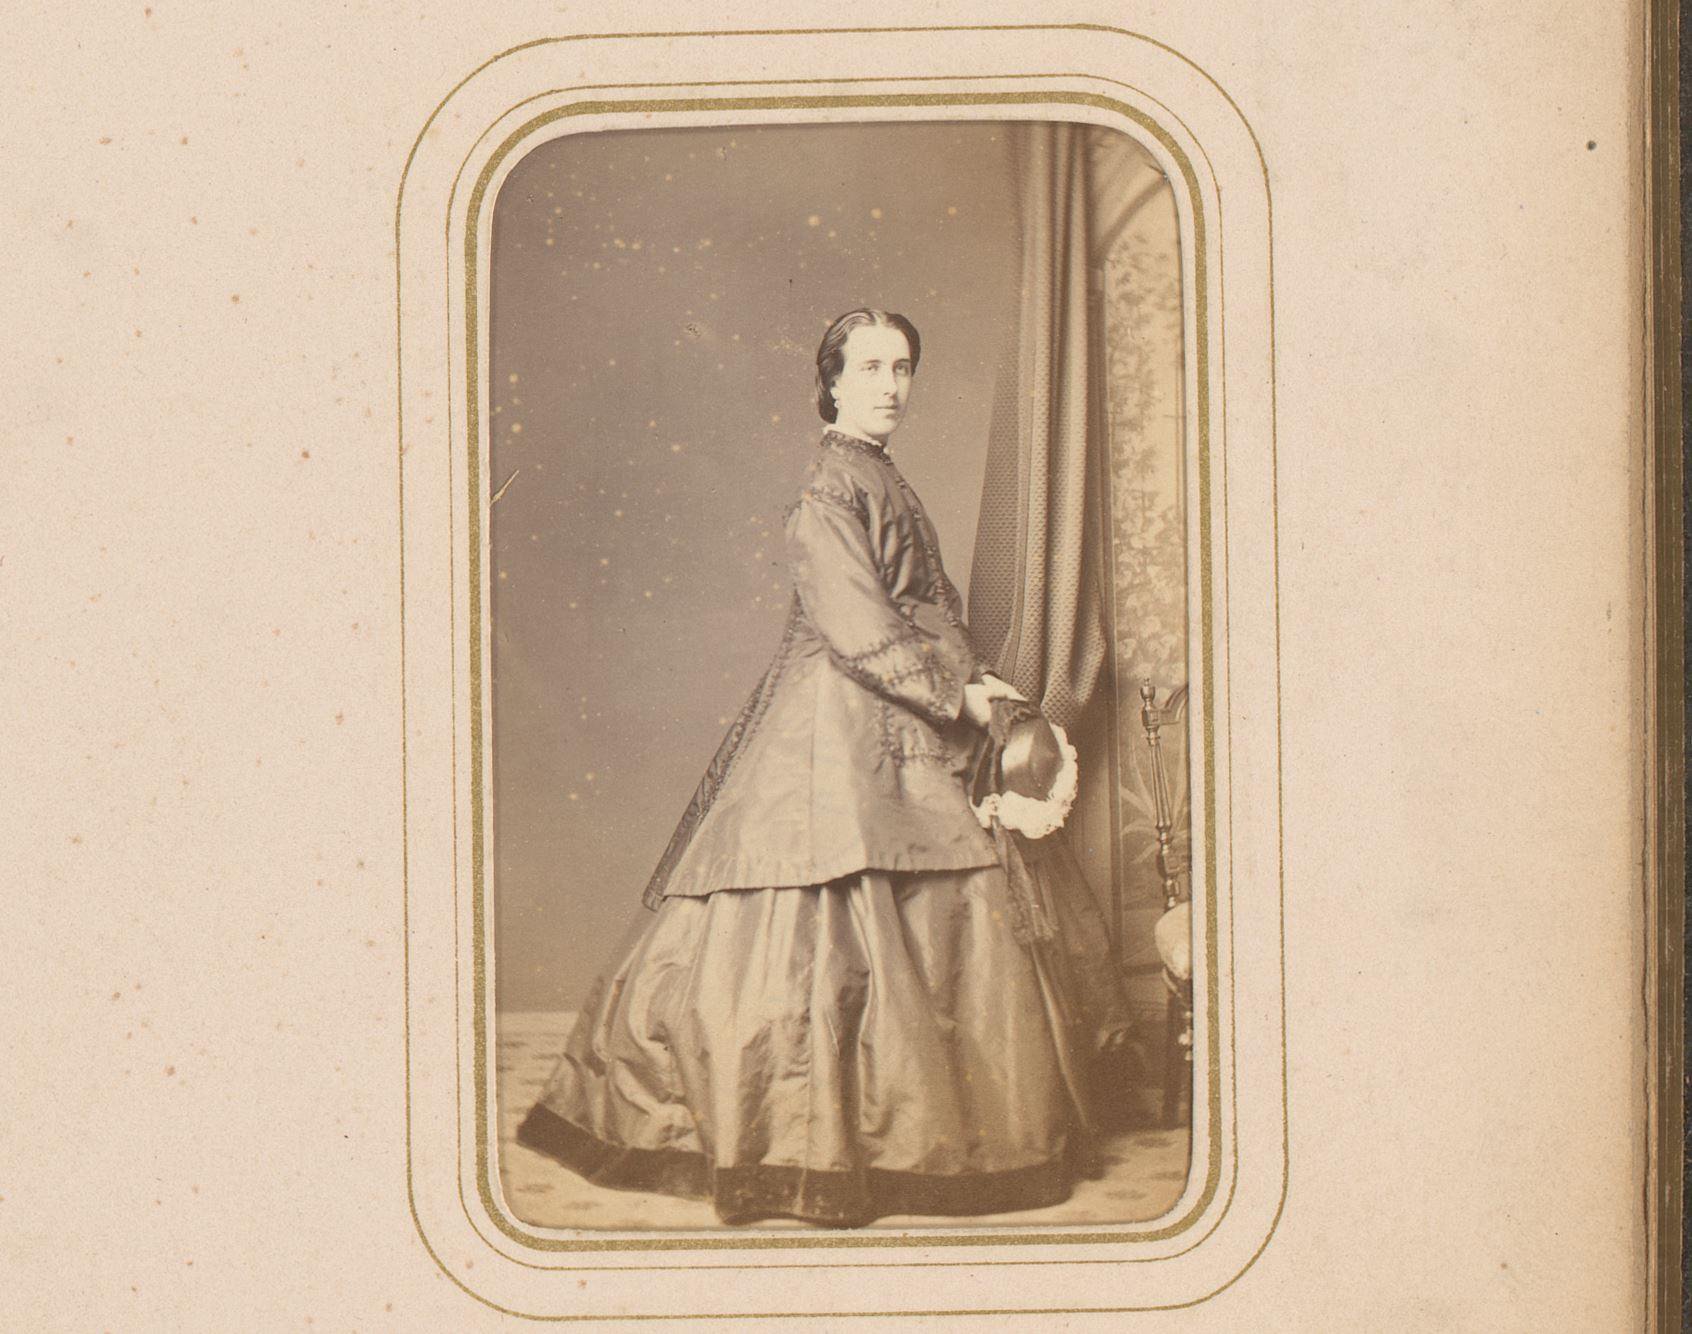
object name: album leaf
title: Portret van een staande vrouw met hoed in de hand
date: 1854-1875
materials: cardboard, photographic support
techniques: albumen print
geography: london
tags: sitting figure - aa - female human figure, historical persons - bb - woman, head-gear: hat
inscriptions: inscription: ‘The London School of Photography/ Mr S. PROUT NEWCOMBE/ 103, Newgate Street/ 174, Regent Street/ 52, Cheapside E.C./ Pantheon Oxford Street/ 23, Poultry E.C./ Myddelton Hall N./ 52, King William Street E.C./ 46, Church Street Liverpool.’